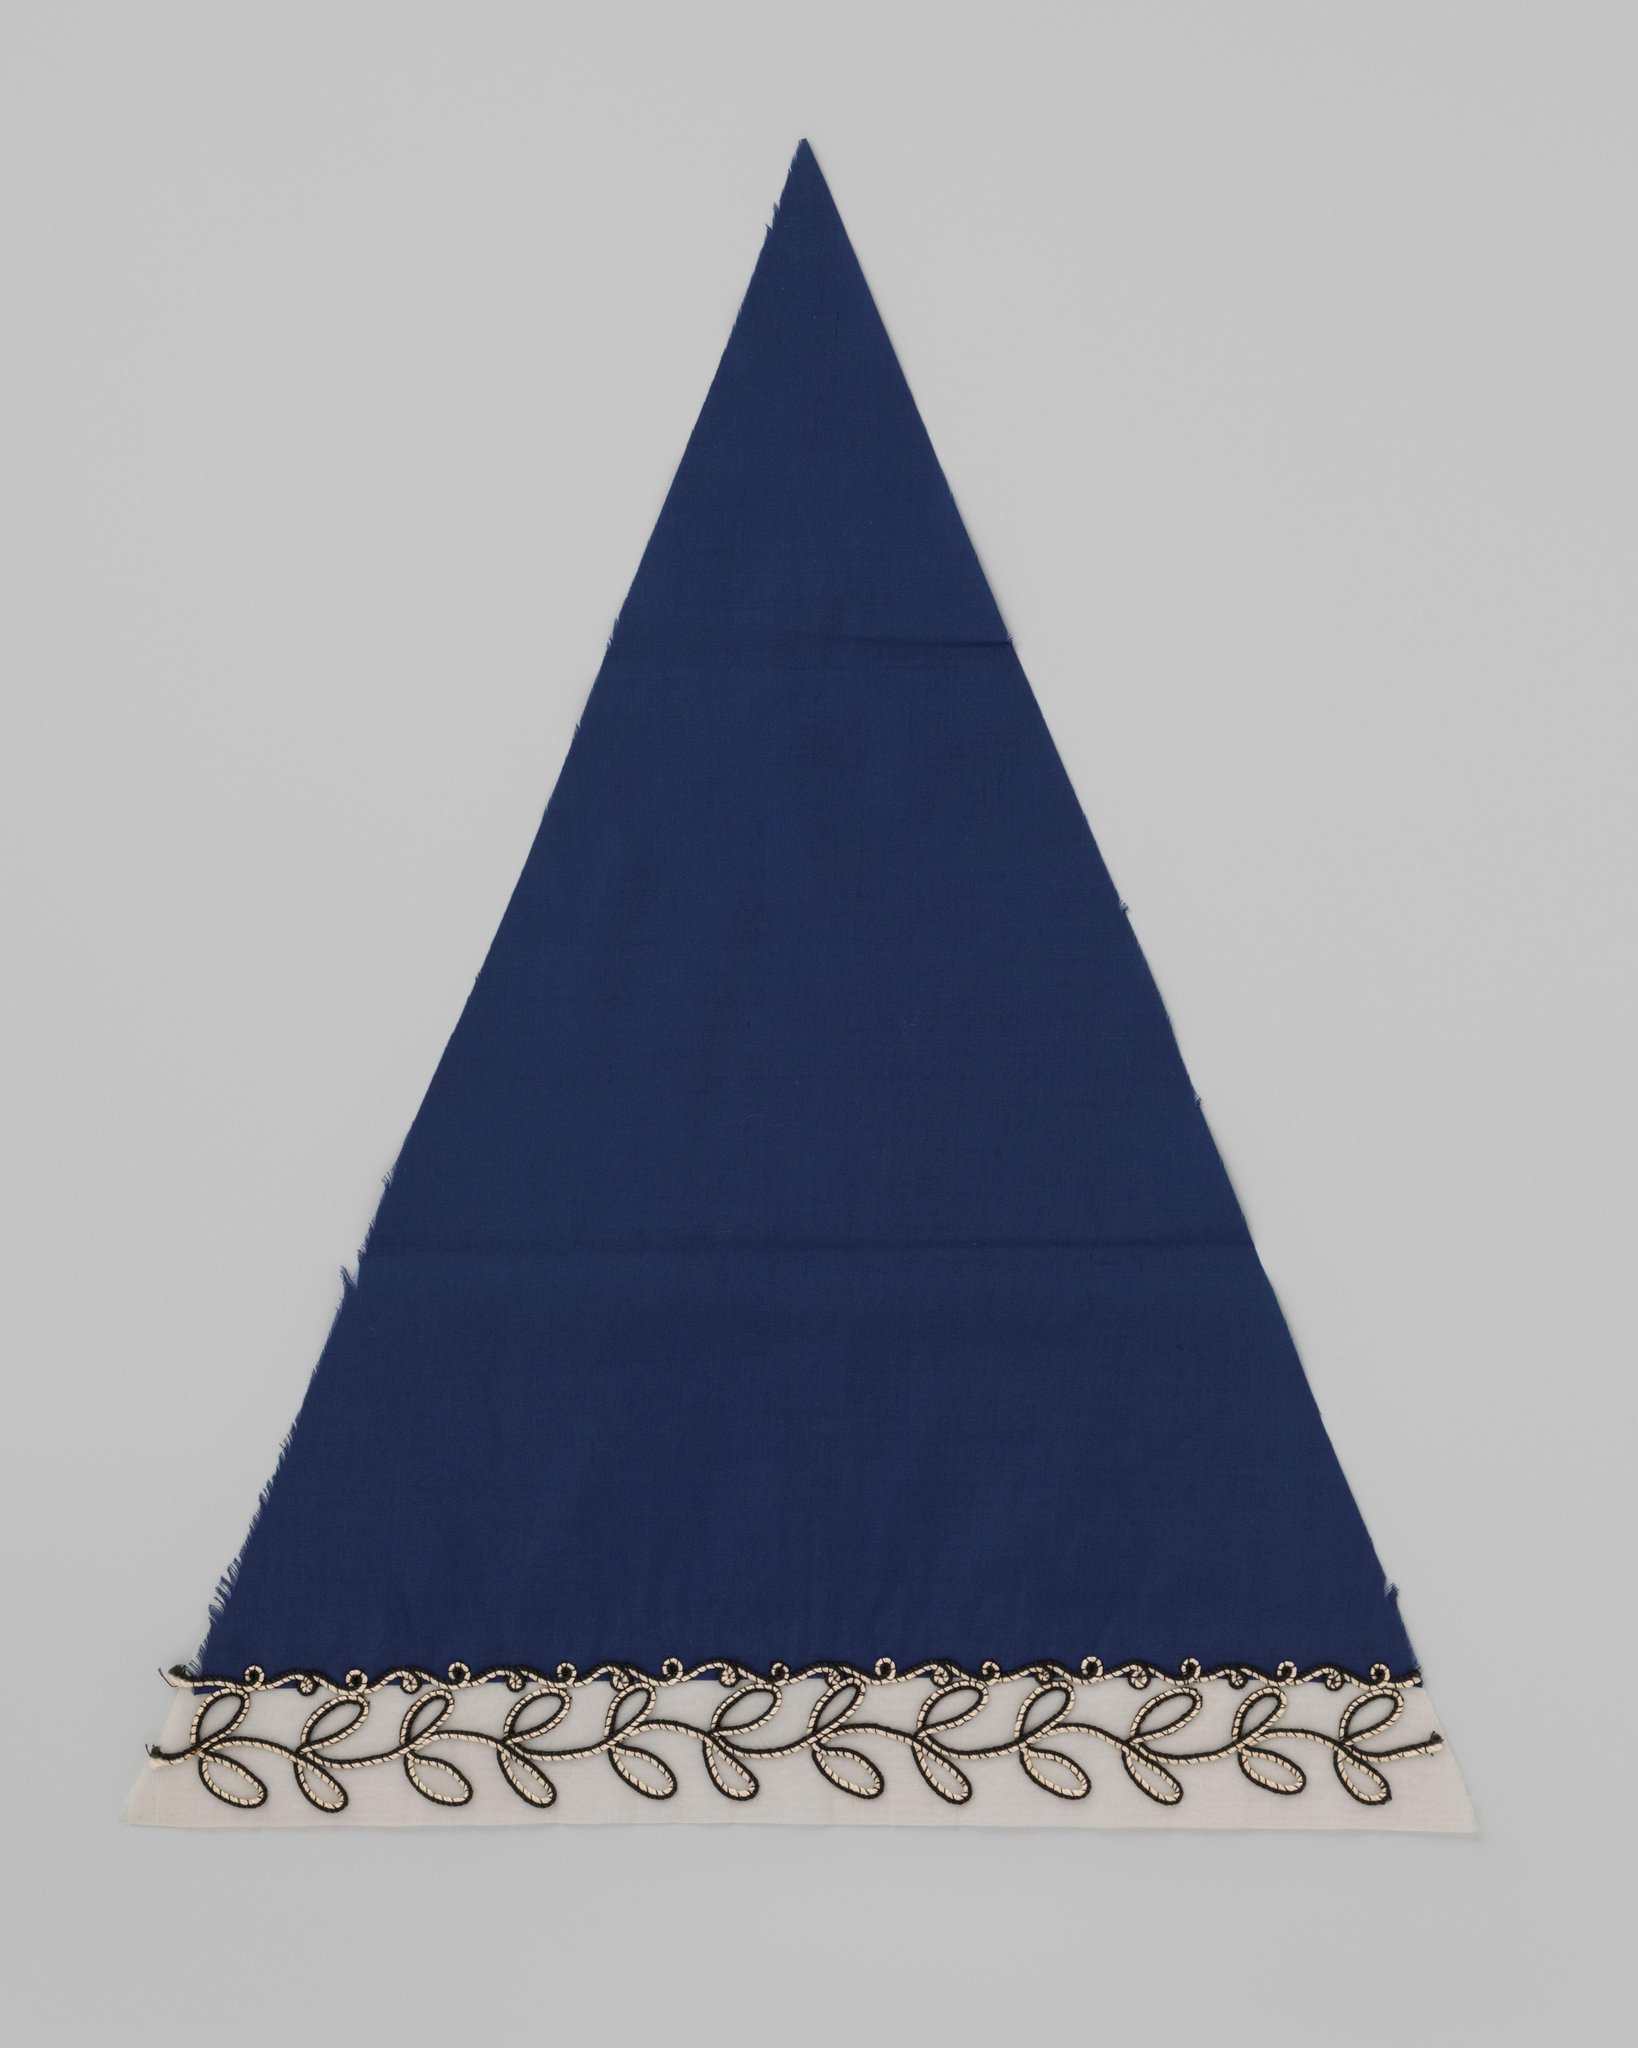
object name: parasoldek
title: Sector van een parasoldek van donkerblauw katoen, met een met woldraad geborduurde rand van batist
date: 1885-1900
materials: cotton, wool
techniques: embroidered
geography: nijmegen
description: Sector van een parasoldek van donkerblauw katoen, met een met woldraad geborduurde rand van batist.